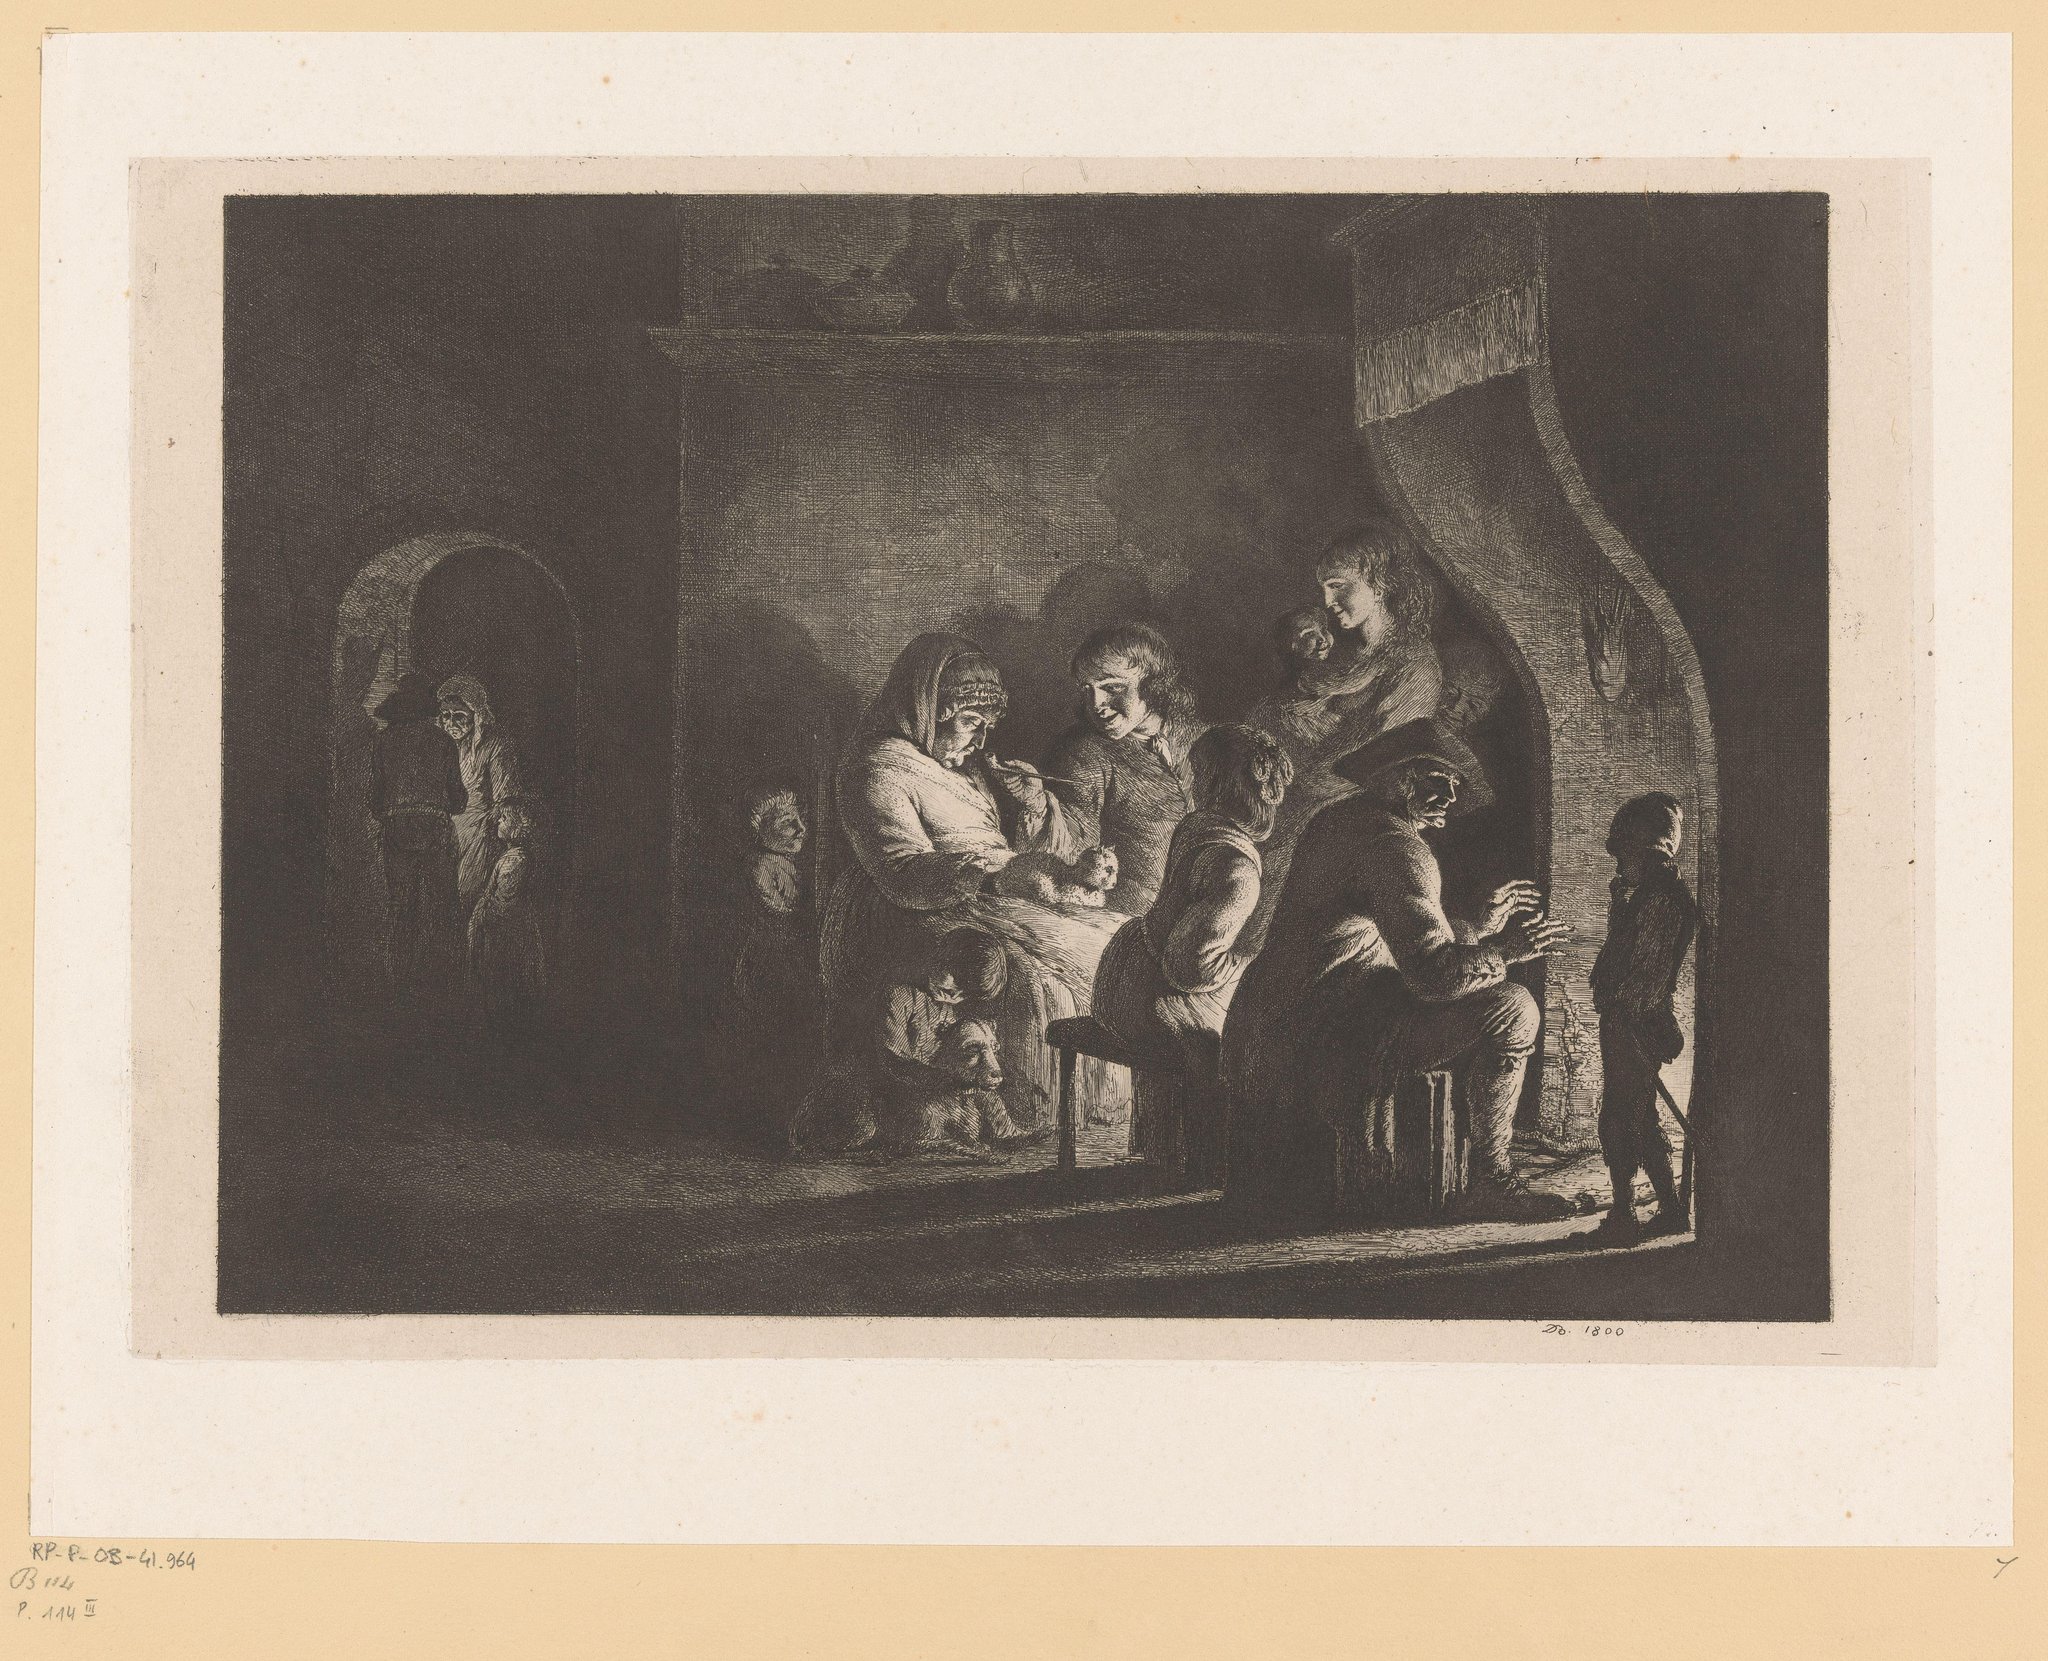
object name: print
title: Boerenfamilie rond een haardvuur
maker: jean jacques de boissieu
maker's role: draughtsman, print maker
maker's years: 1736-1810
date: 1800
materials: paper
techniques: drypoint, etching, roulette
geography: france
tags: cat, open hearth, fire-place, farmers, family, descendance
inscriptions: collector's mark: Lugt 12